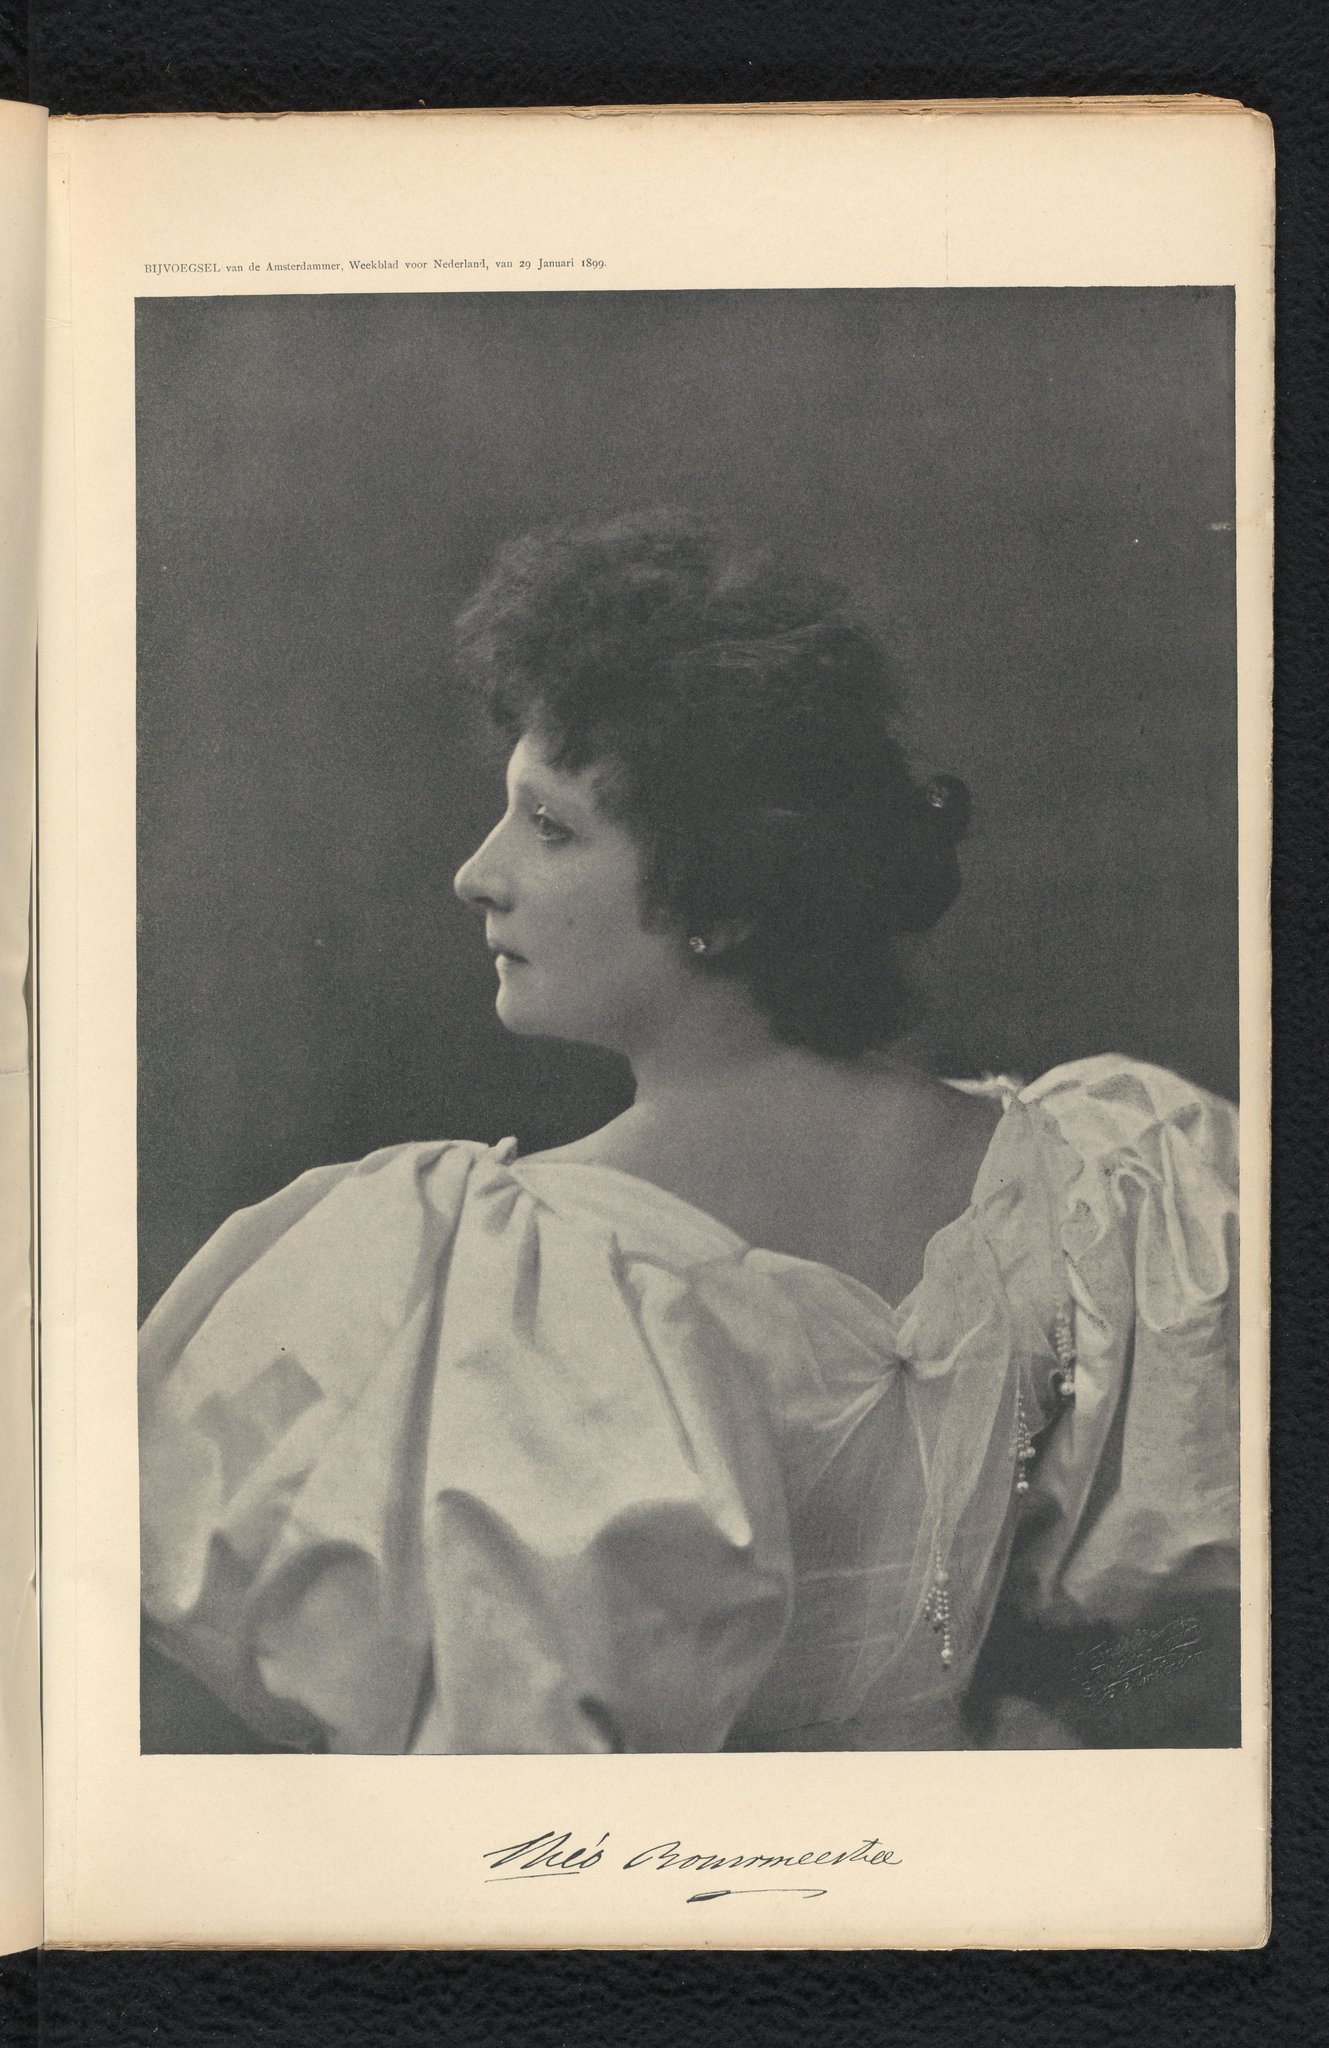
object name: photomechanical print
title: Theo Bouwmeester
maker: Anonymous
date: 1899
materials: paper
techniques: autotype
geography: netherlands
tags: amsterdam, historical persons - bb - woman, portrait of actor, actress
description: Gepubliceerd als bijvoegsel bij 'De Amsterdammer' van 29 januari 1899.